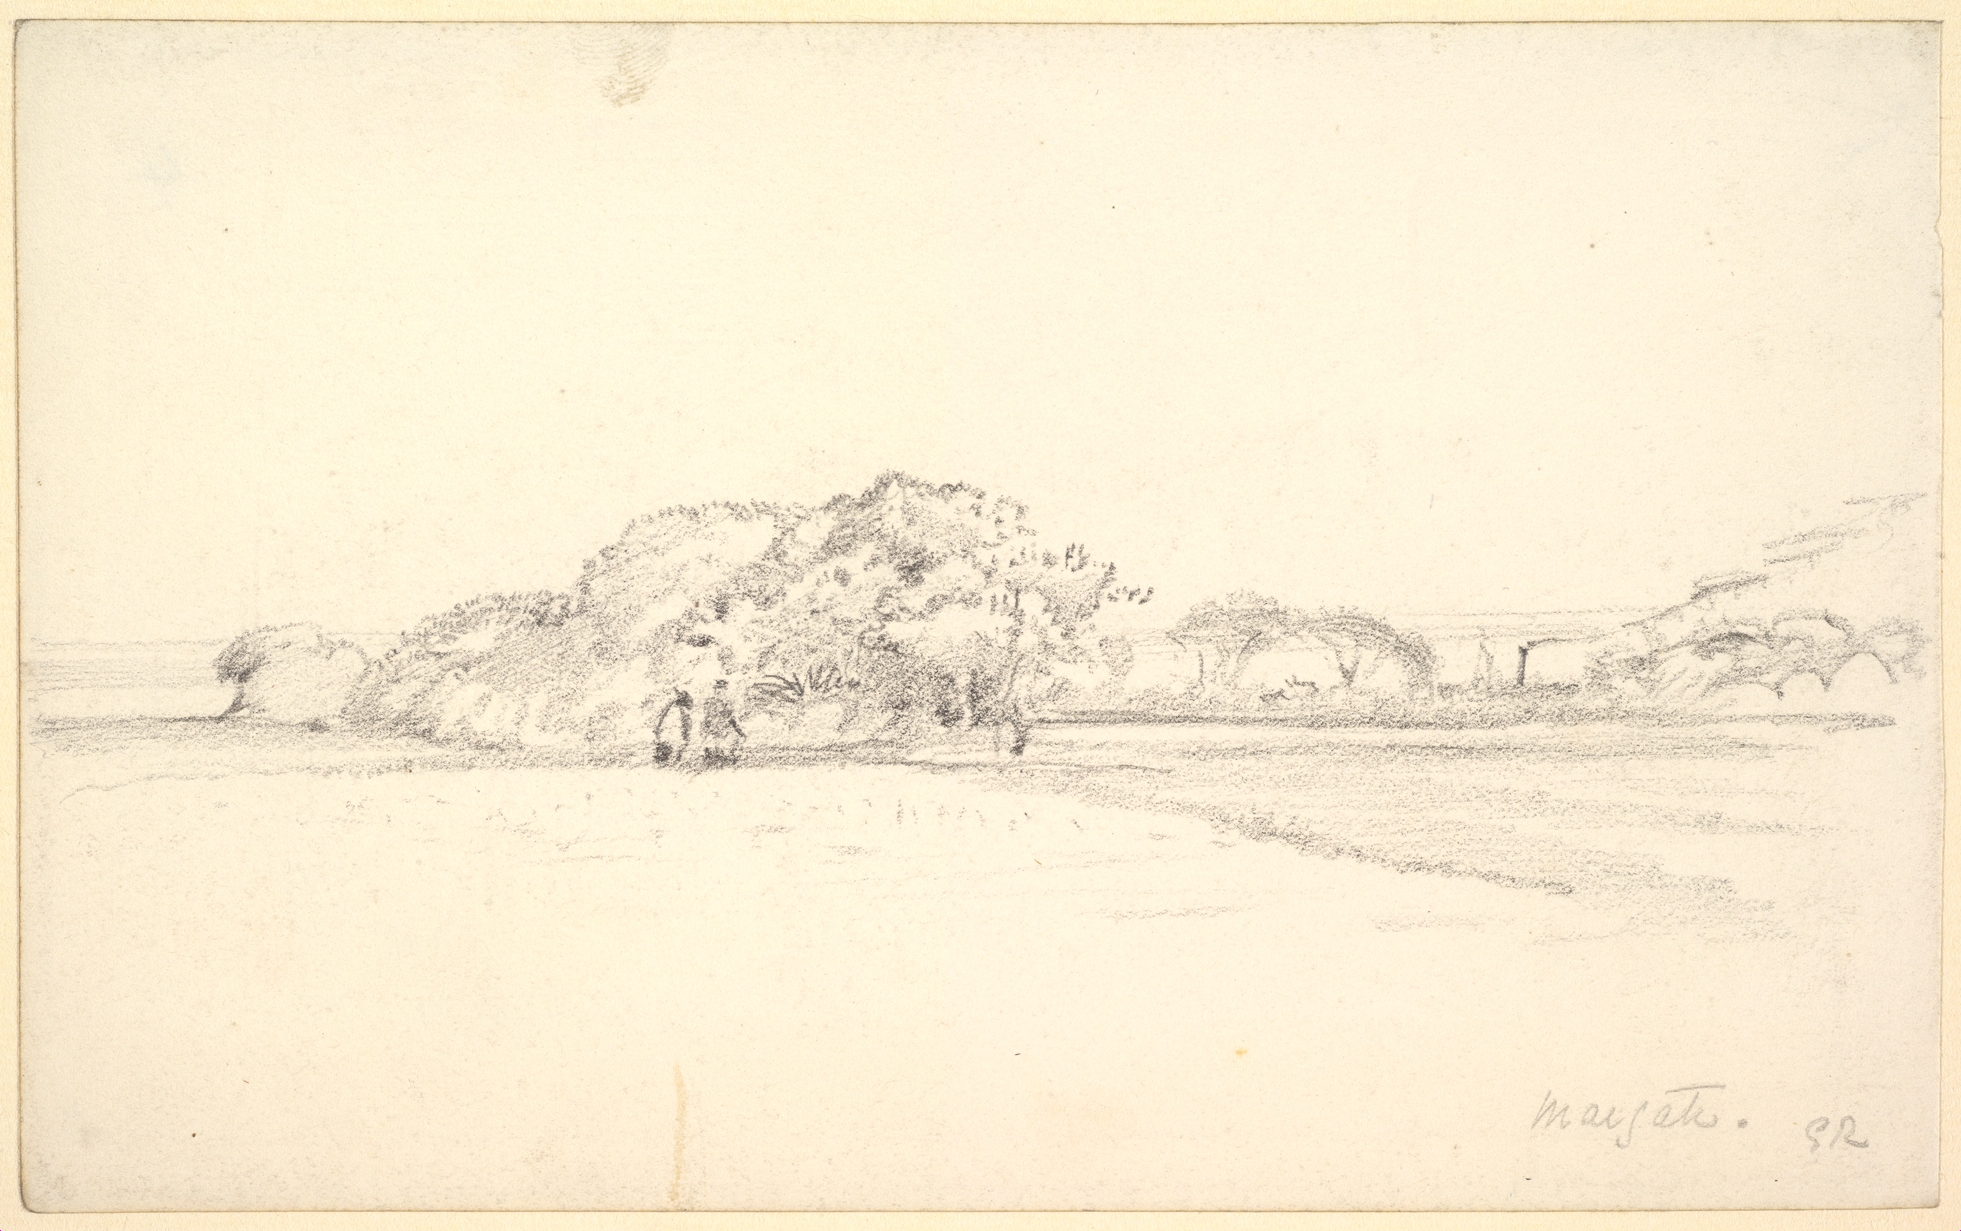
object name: drawing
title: Landscape at Margate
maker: george richmond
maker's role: artist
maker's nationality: british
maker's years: 1809-1896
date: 1840-1860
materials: chalk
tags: landscapes